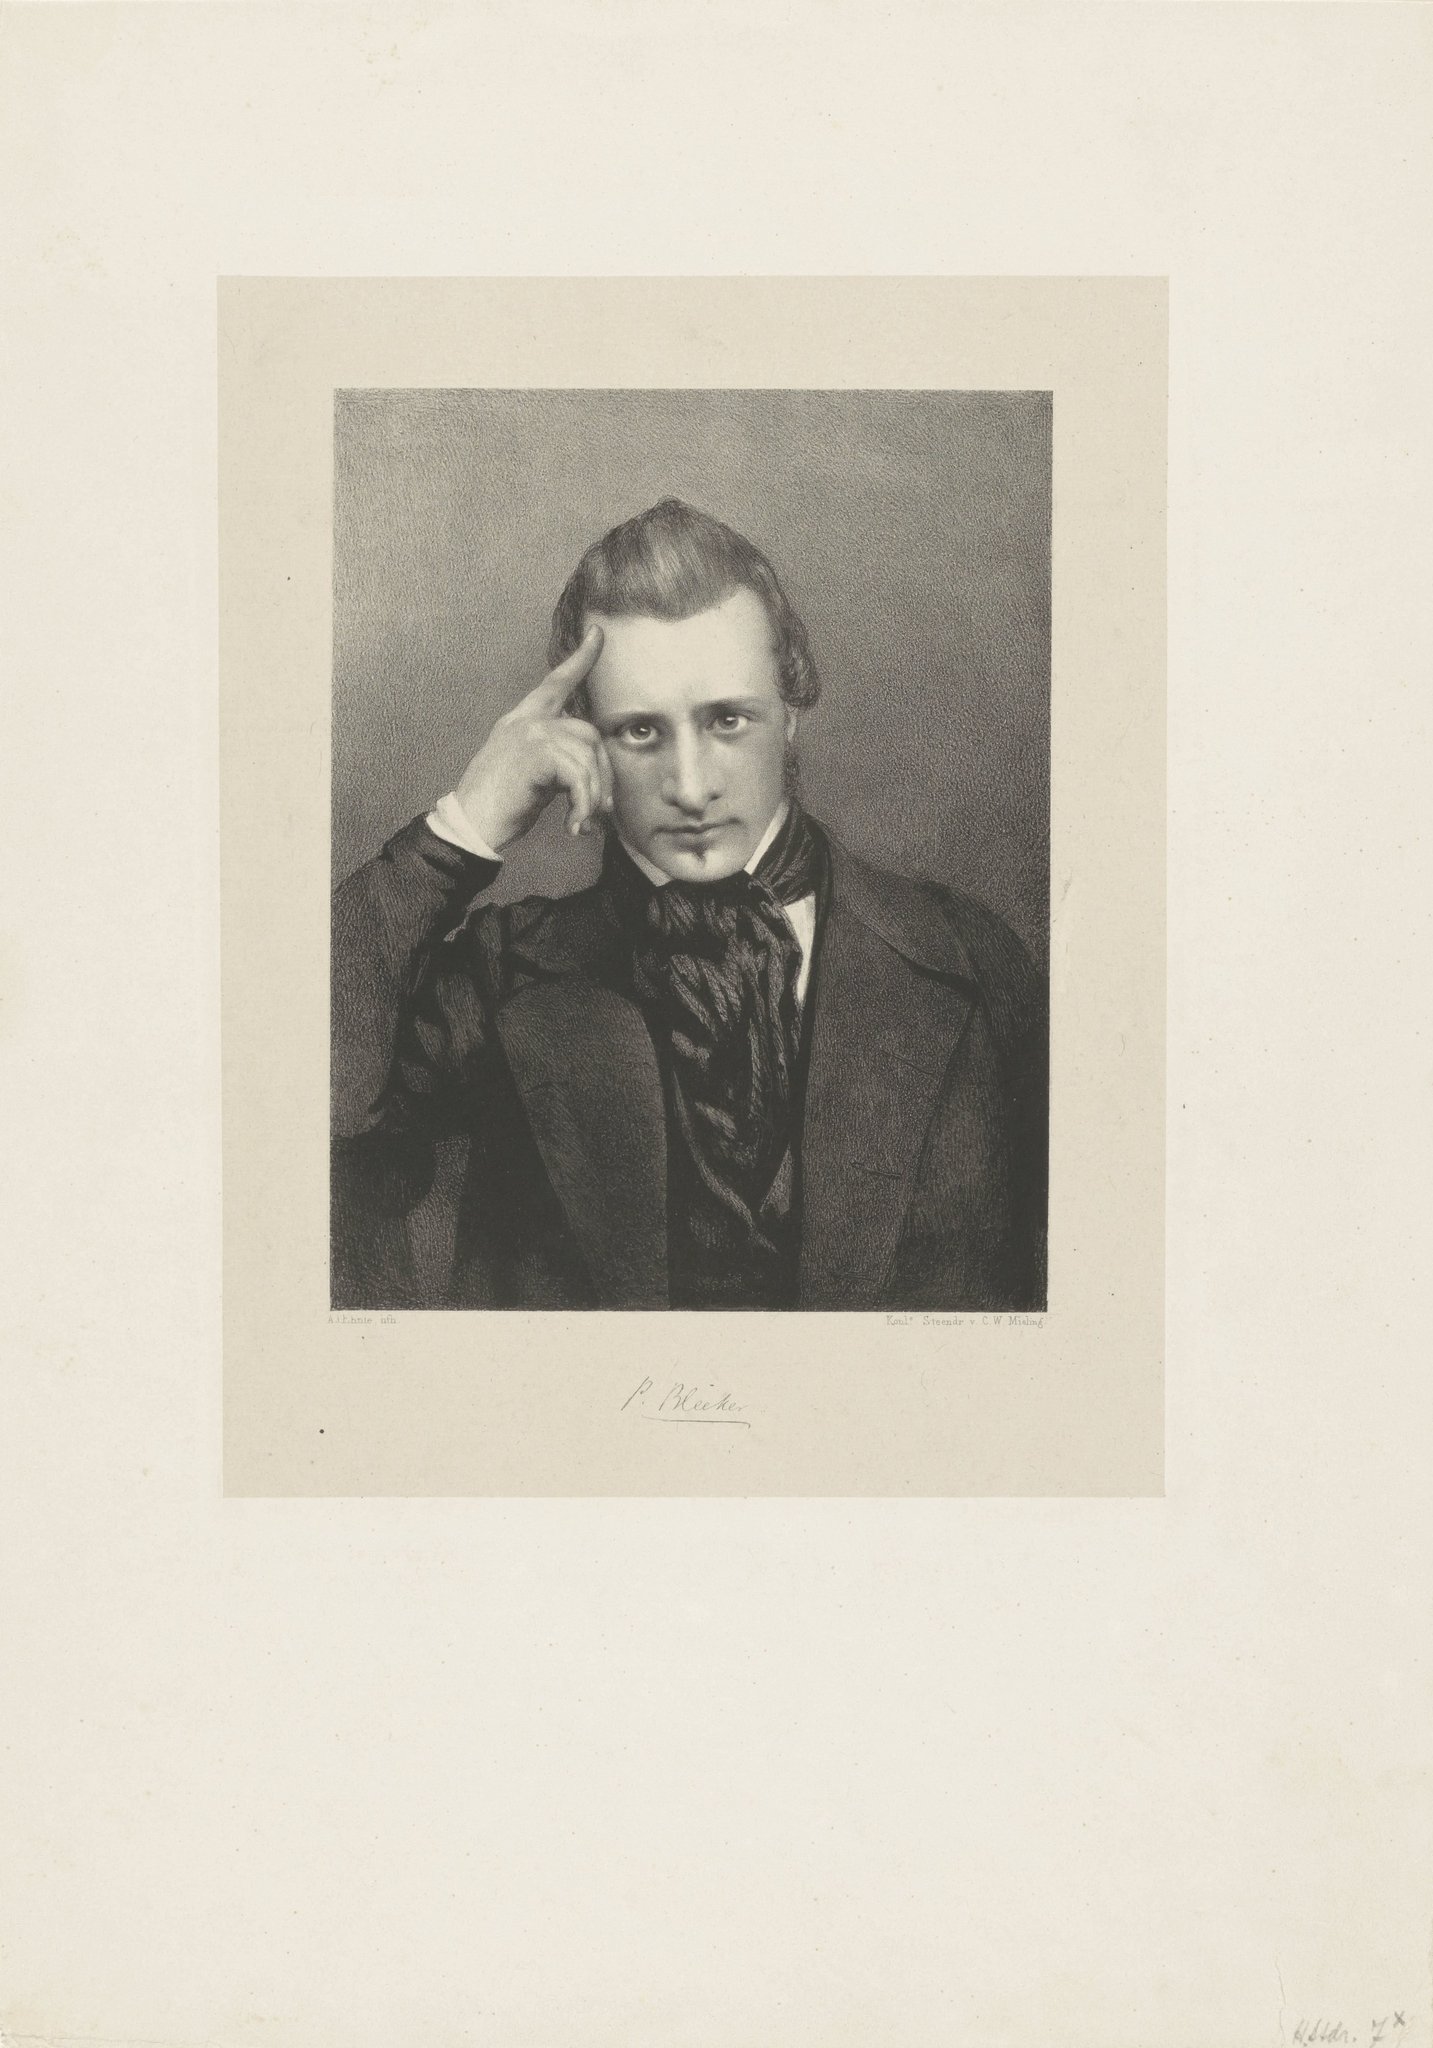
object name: print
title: Portret van Pieter Bleeker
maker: adrianus johannes ehnle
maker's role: draughtsman, print maker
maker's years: 1819-1863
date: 1829-1863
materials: paper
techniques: lithograph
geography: the hague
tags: historical persons (+ (full) bust portrait)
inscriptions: collector's mark: Lugt 2228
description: De geportretteerde is frontaal afebeeld. Hij houdt zijn rechterhand bij zijn hoofd. Onder het portret zijn signatuur.